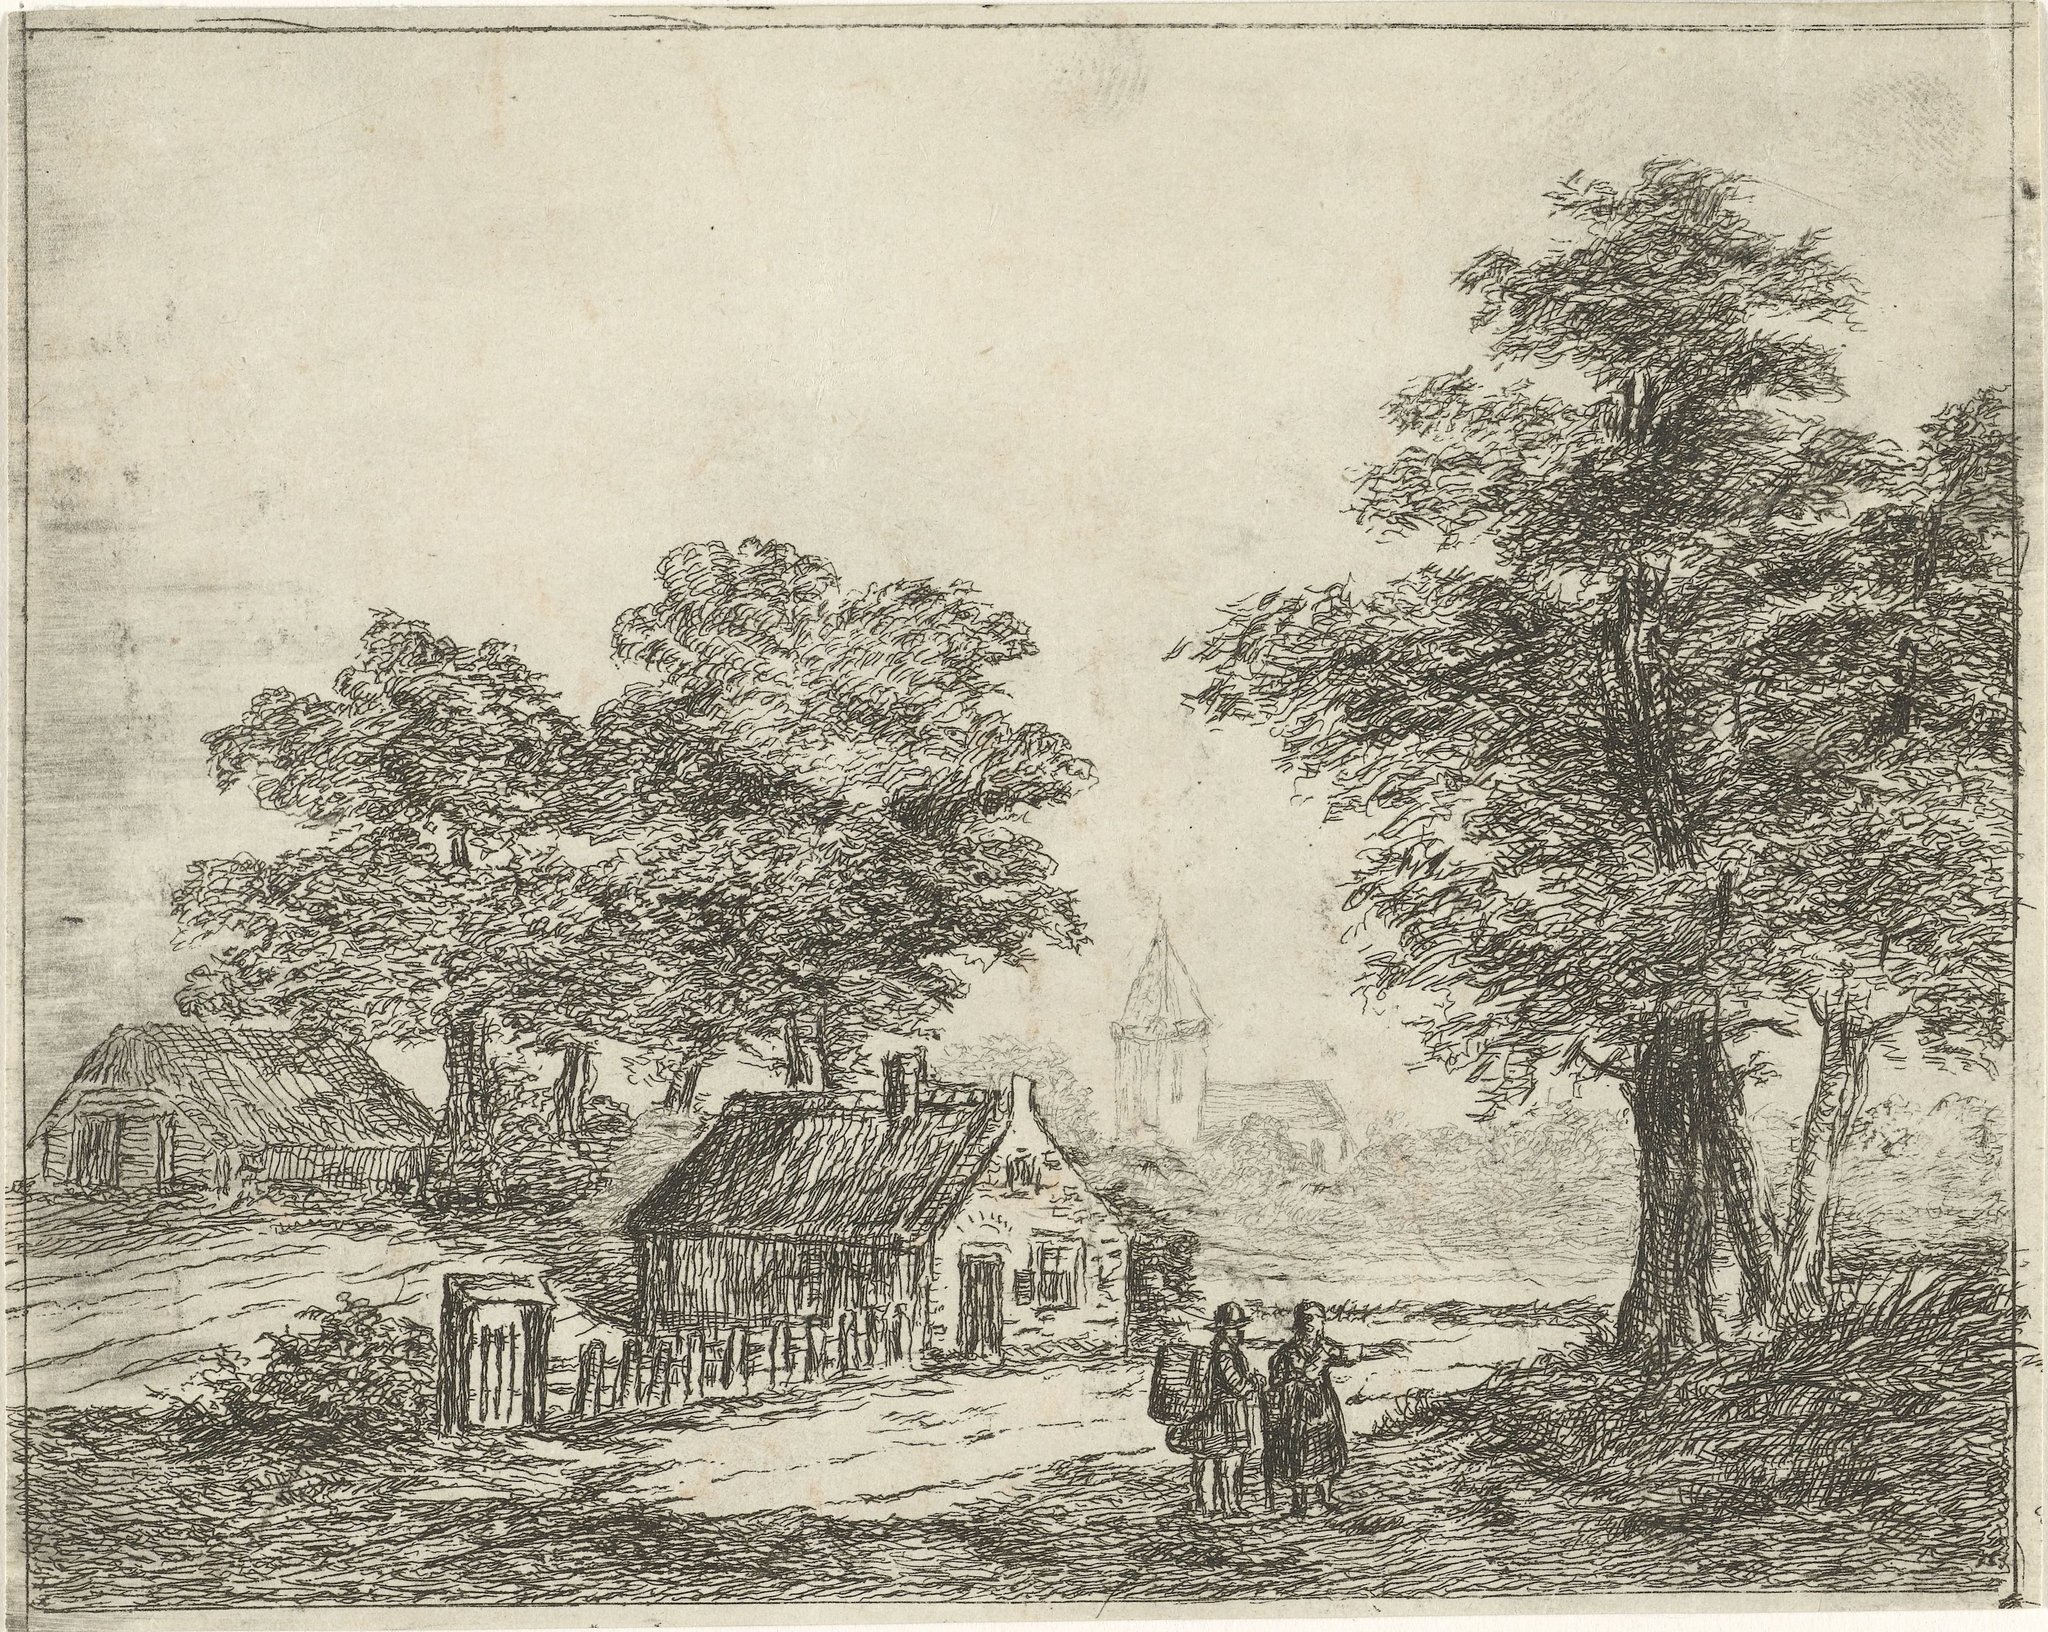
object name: print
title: Landschap met wandelaars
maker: david van der kellen (1804-1879)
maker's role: die cutter, draughtsman, print maker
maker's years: 1804-1879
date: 1814-1879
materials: paper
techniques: etching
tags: church (exterior), farm or solitary house in landscape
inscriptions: collector's mark: Lugt 2228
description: Een man en een vrouw lopen over een pad met bomen en twee huizen. Op de achtergrond is een kerktoren te zien.